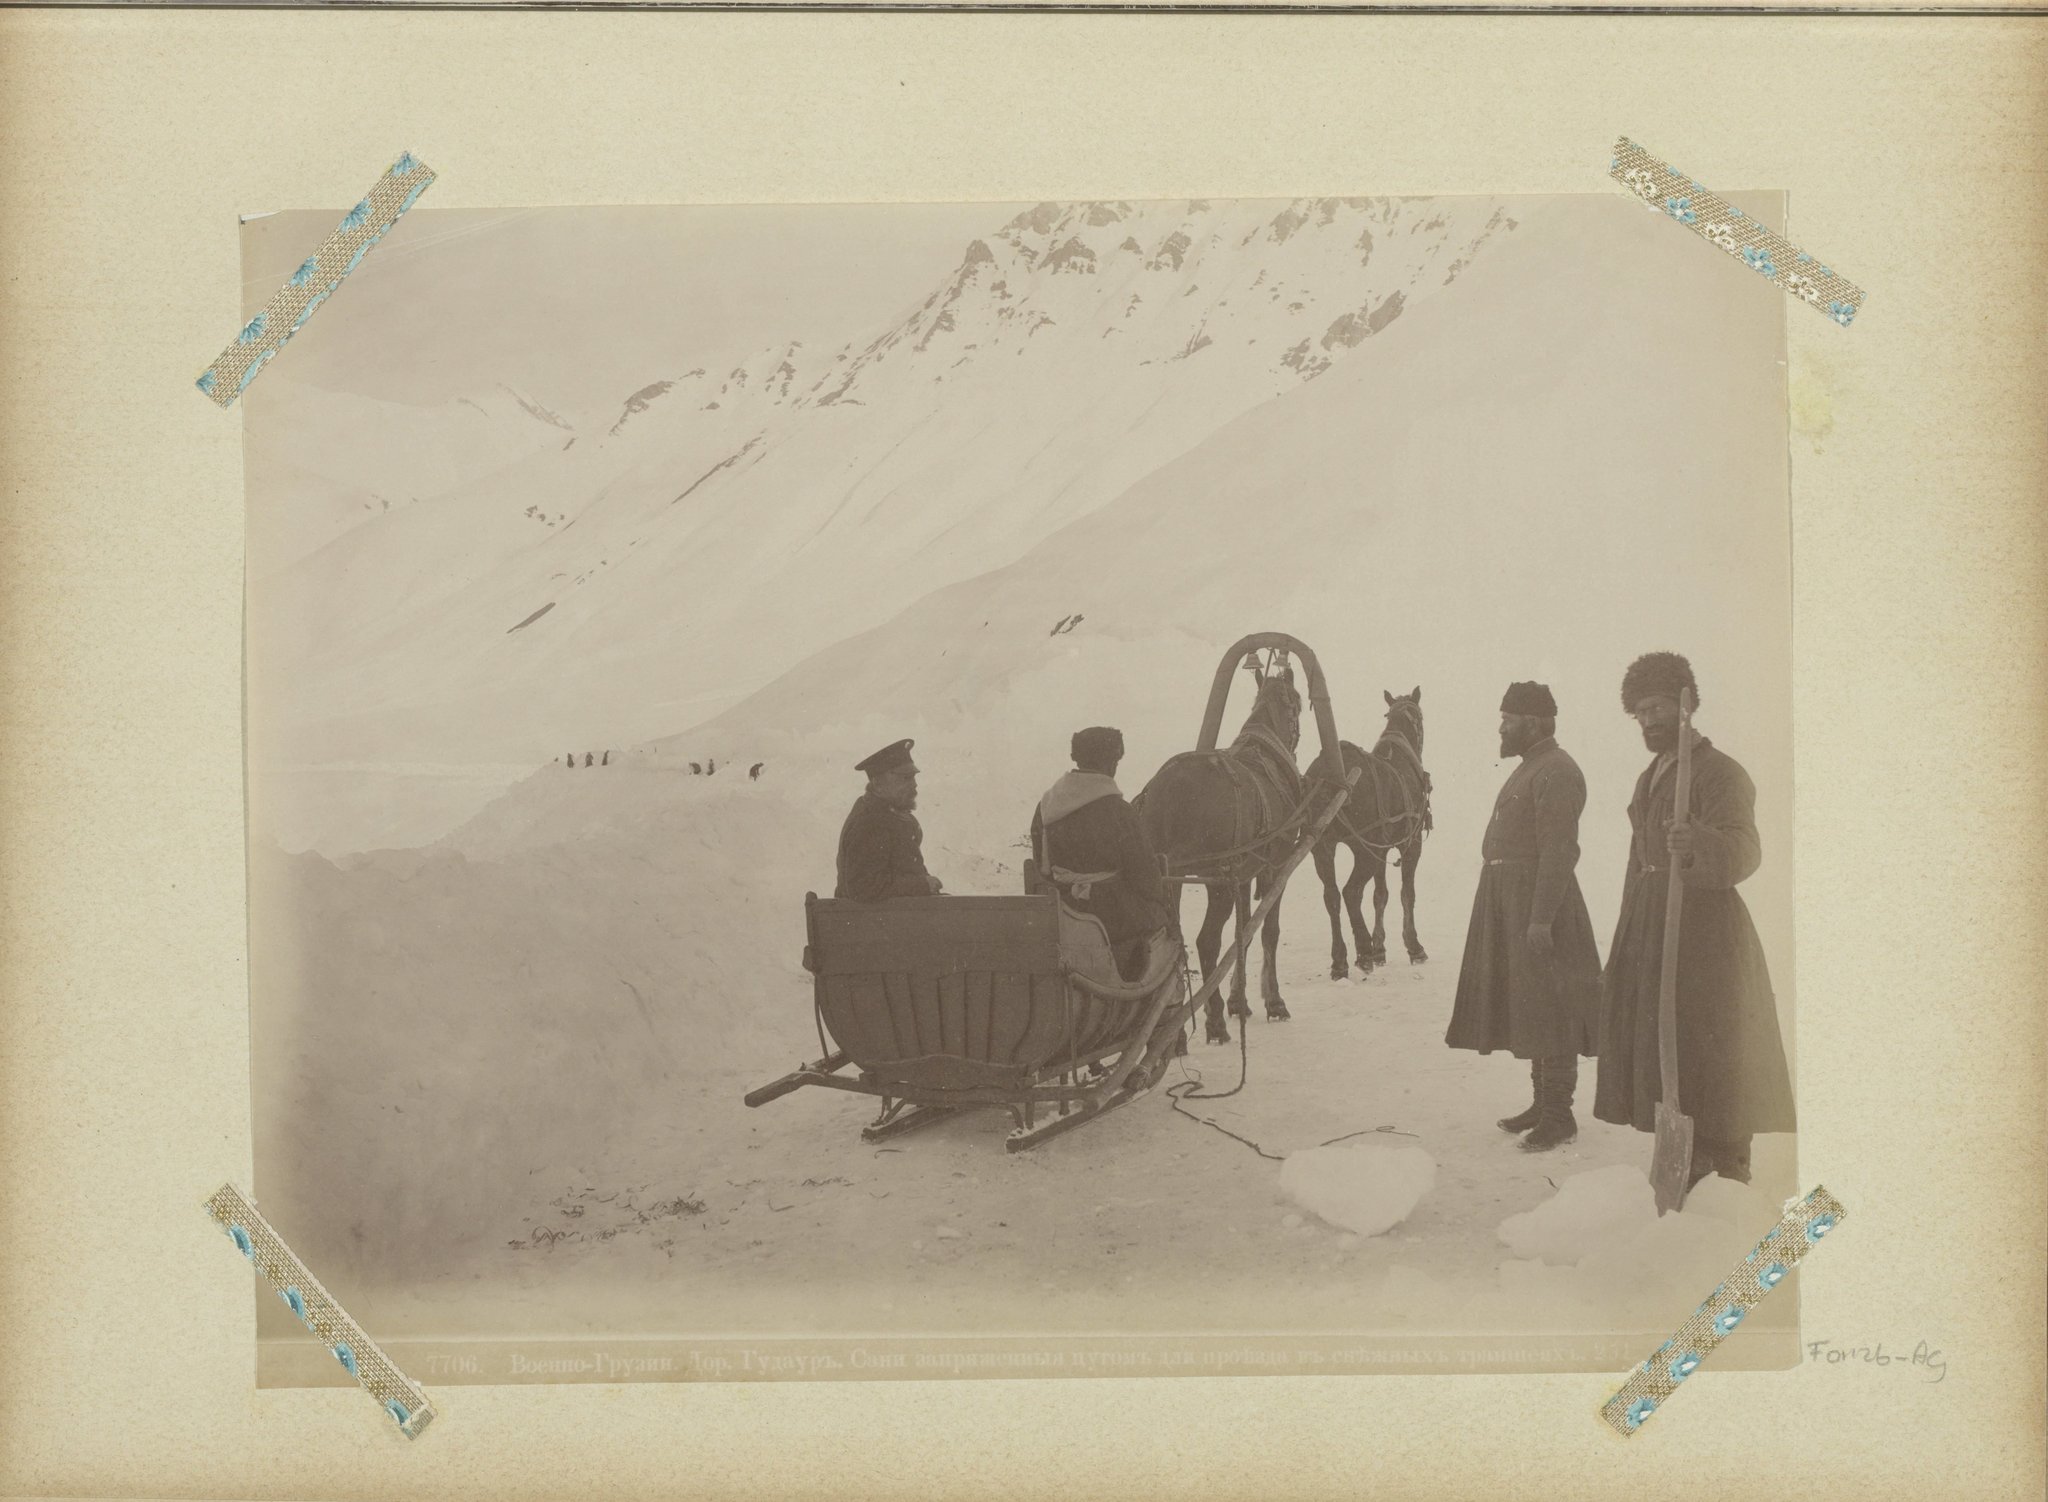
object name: photograph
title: Paardenslee en sneeuwruimers op de militaire weg in Georgië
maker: dimitri ivanovitch ermakov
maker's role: fotograaf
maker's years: 1845-1916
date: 1890-1900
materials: photographic support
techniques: albumen print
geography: georgia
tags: horse-sleigh, mountain-range, snow peaks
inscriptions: number: ‘251’, number: ‘7706’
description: Onderdeel van Fotoalbum met opnames van bezienswaardigheden in Georgië, Sint-Petersburg en Moskou.